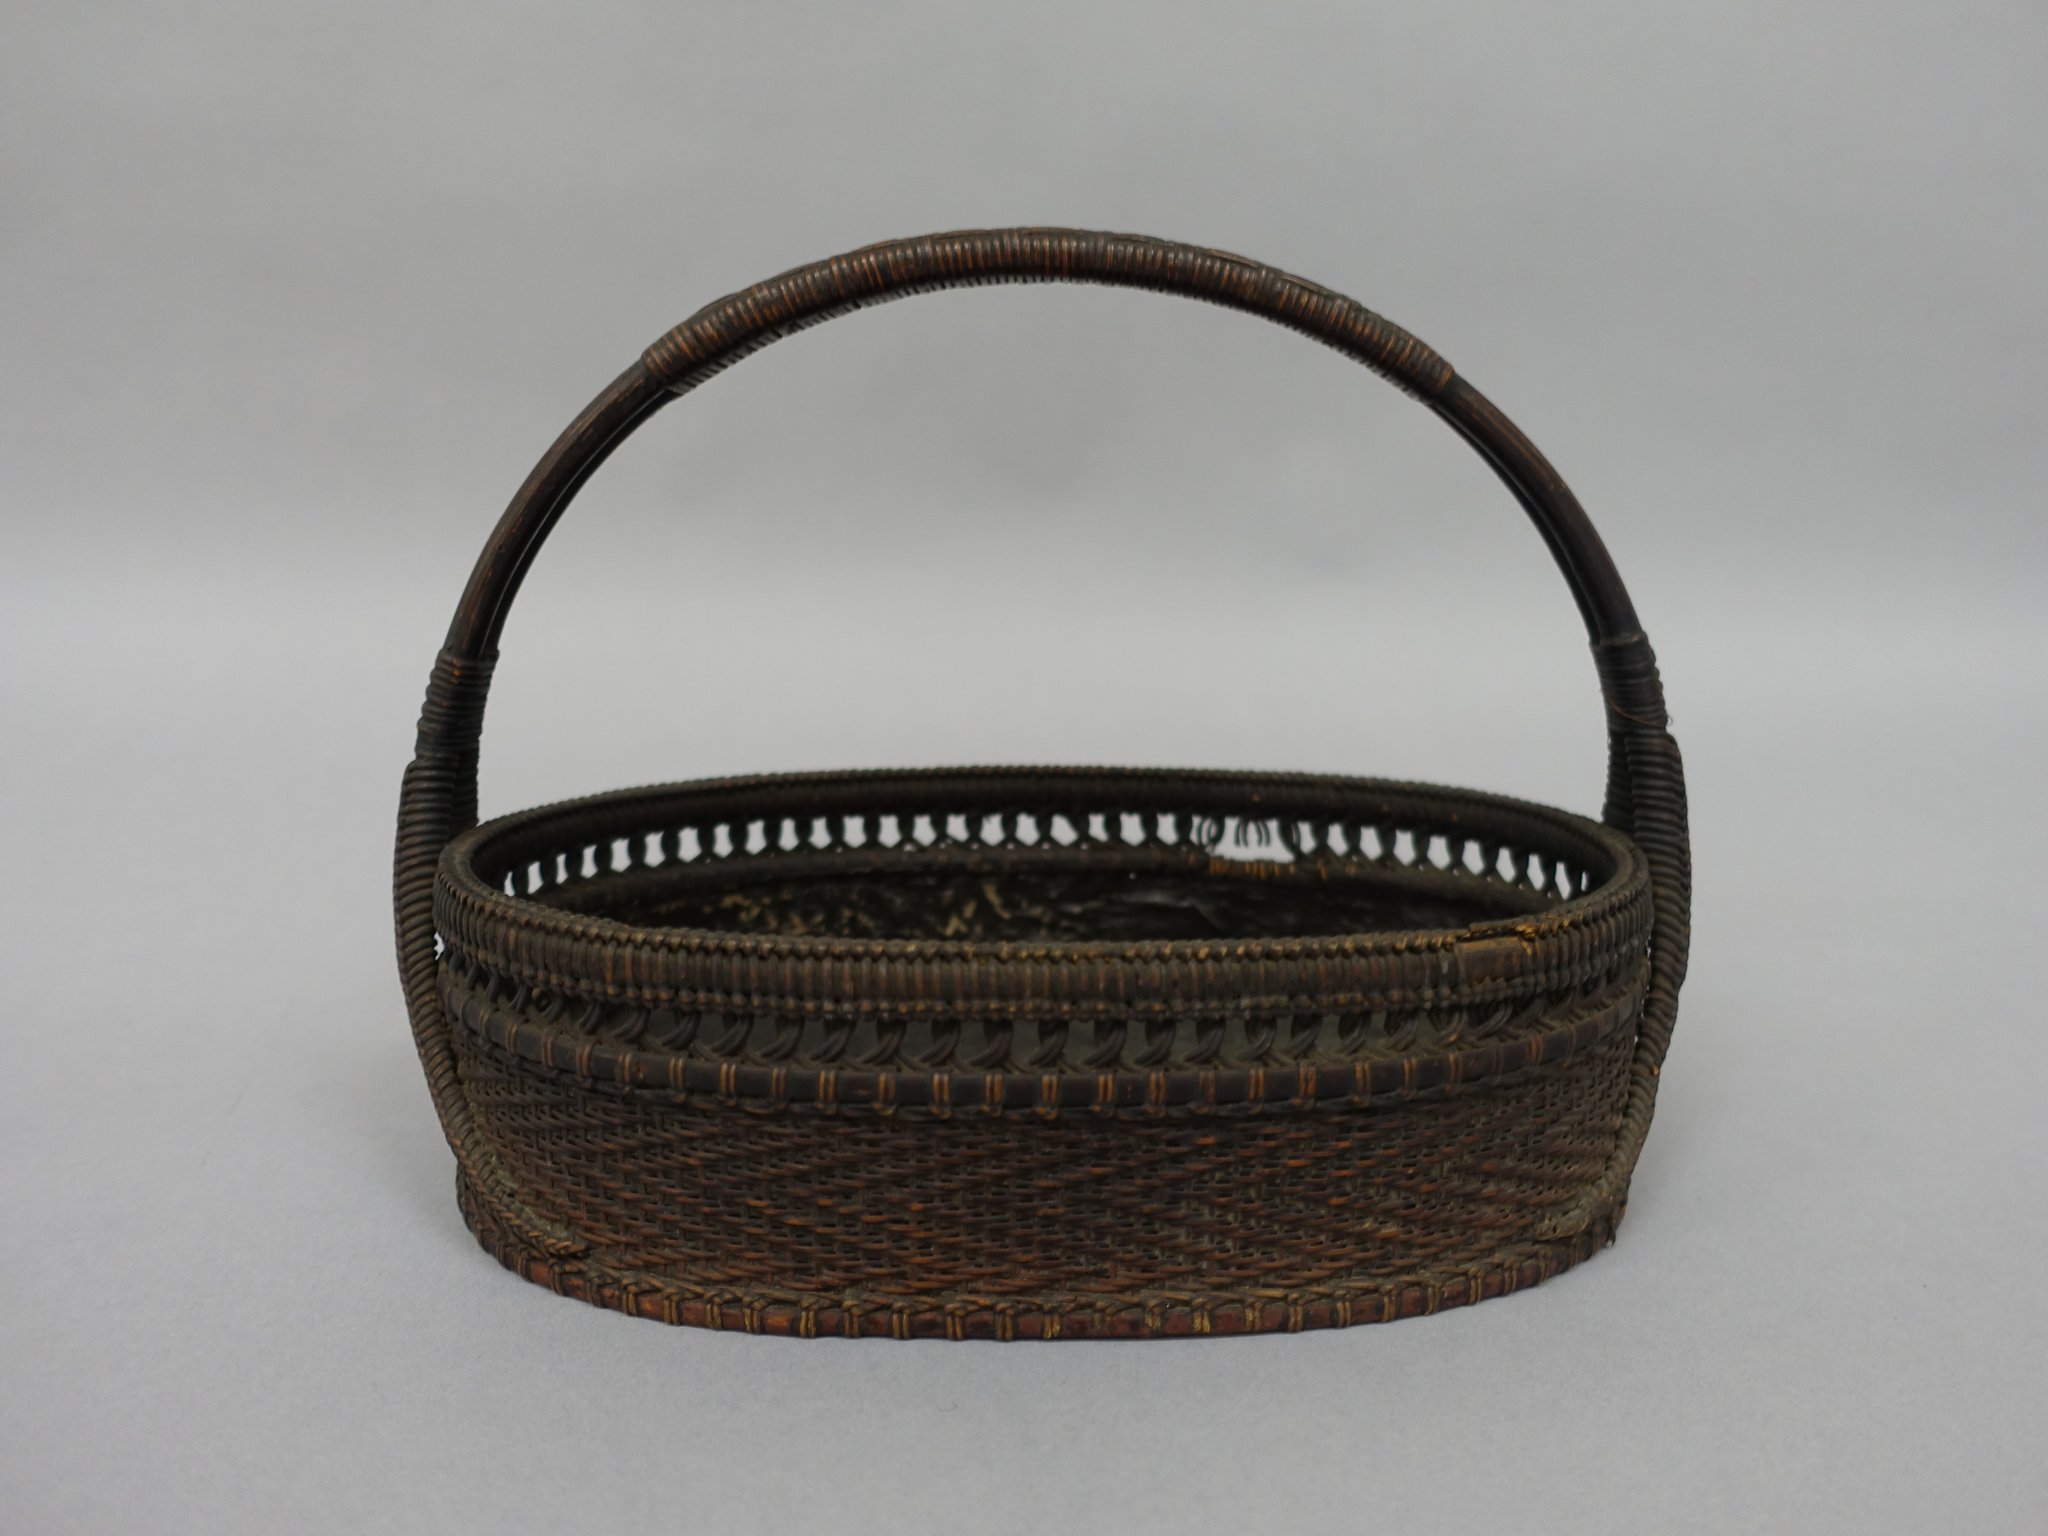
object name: basket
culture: japanese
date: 1801-1900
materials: bamboo